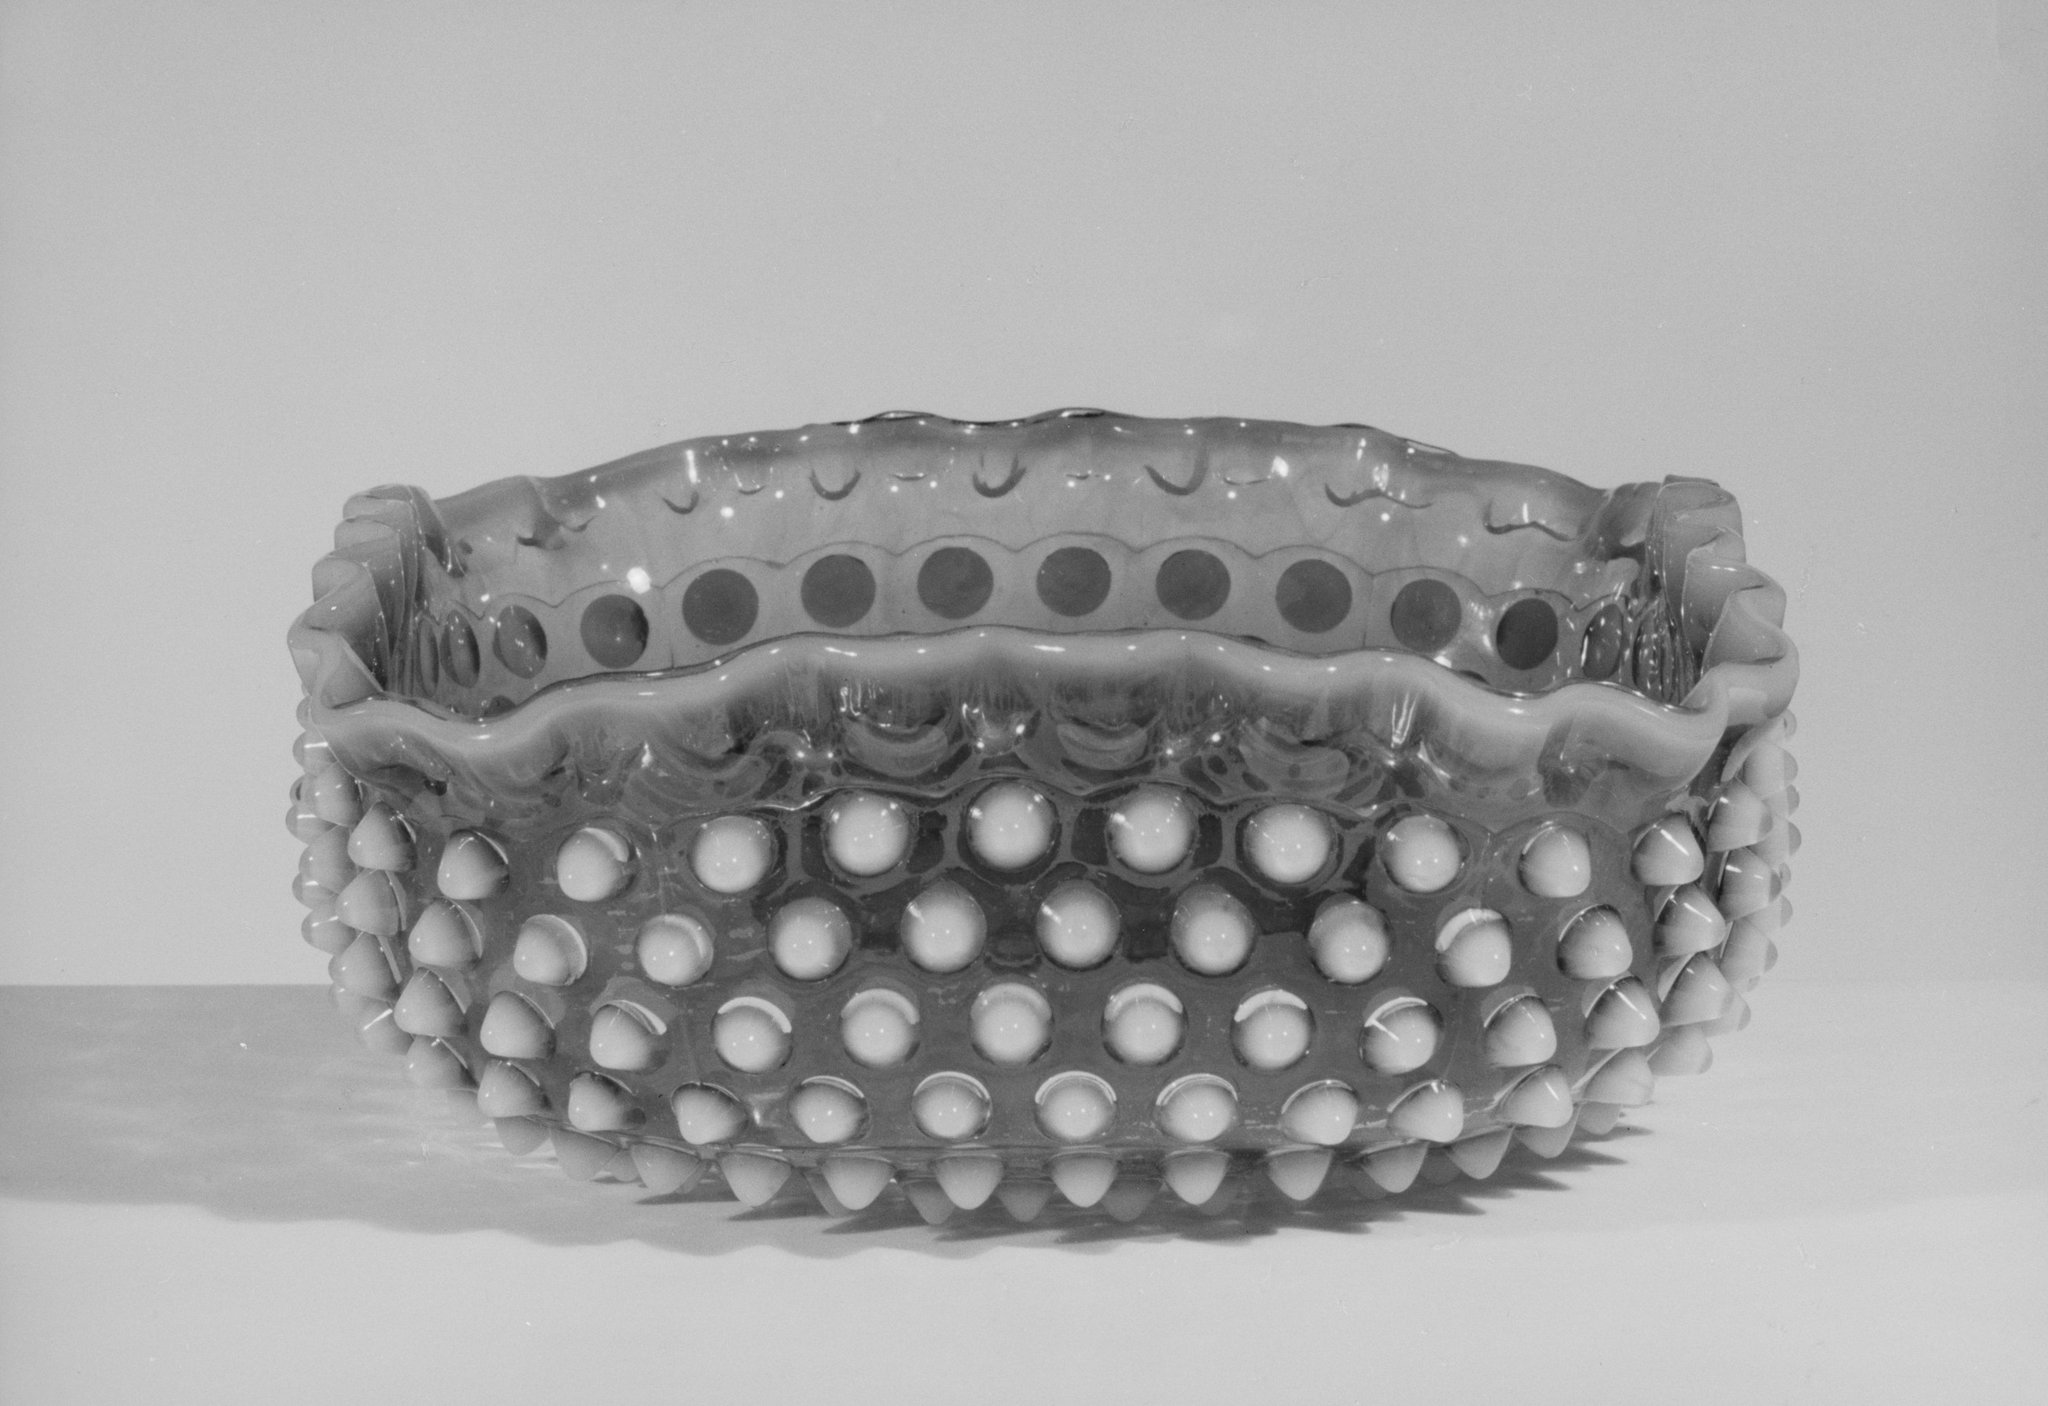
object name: fruit bowl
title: Hobnail Fruit Bowl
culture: american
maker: hobbs, brockunier and company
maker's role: maker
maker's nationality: american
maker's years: 1863-1891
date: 1886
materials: glass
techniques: pressed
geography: united states